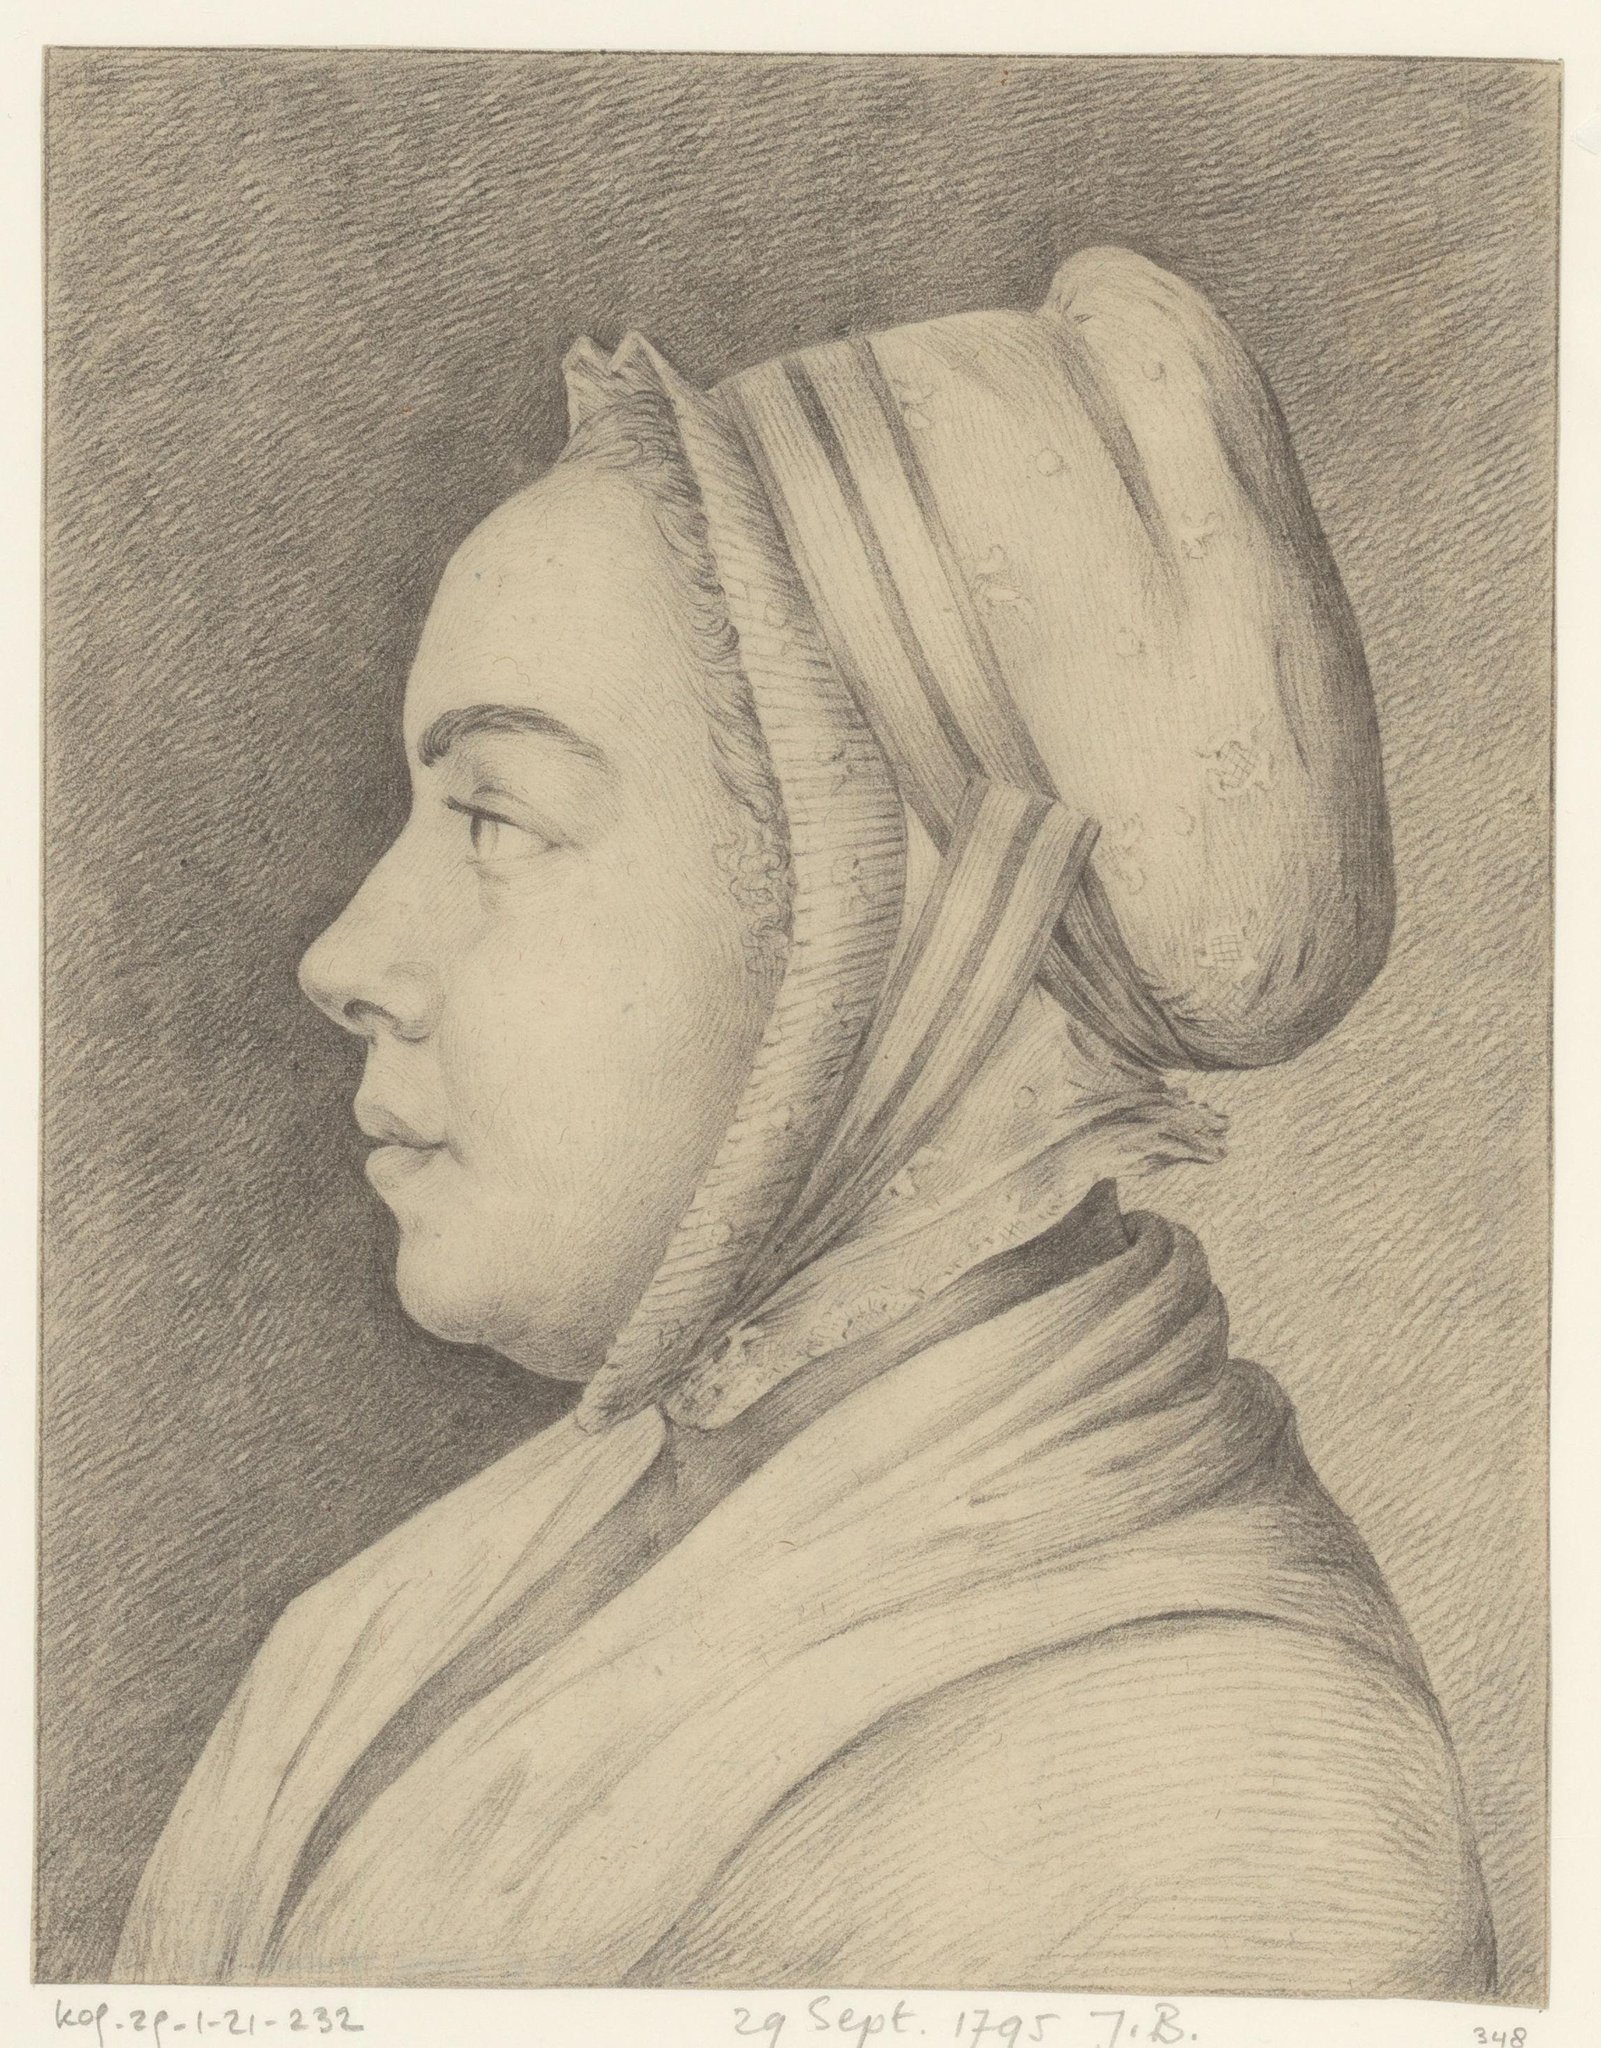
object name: drawing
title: Portret van een jonge vrouw met muts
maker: jean bernard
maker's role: draughtsman, print maker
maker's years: 1765-1833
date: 1795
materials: chalk, paper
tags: historical persons not known by name - bb - woman, head-gear: cap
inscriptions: collector's mark: Lugt 1641, stamp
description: Portret van een jonge vrouw met muts, mogelijk een familielid van de tekenaar. Onderwerpsrubrieken binnen de Atlas Zeden en Gewoonten: Zeden en Gewoonten in Engeren Zin, De Kleeding, Kleederdrachten (tijdvakken), Het begin der 19de eeuw. Mannen en vrouwen.